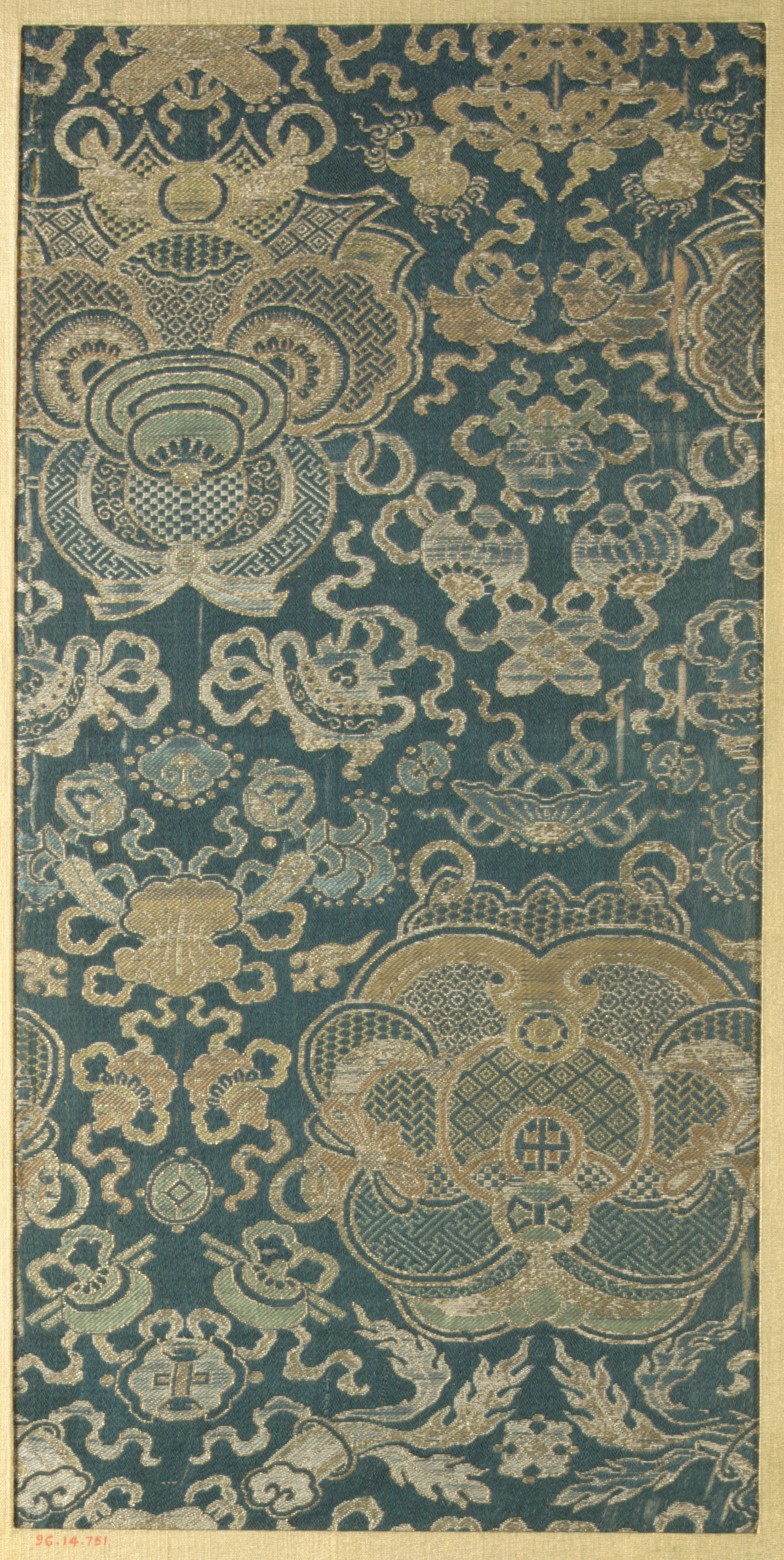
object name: piece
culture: japanese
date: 1701-1900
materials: silk